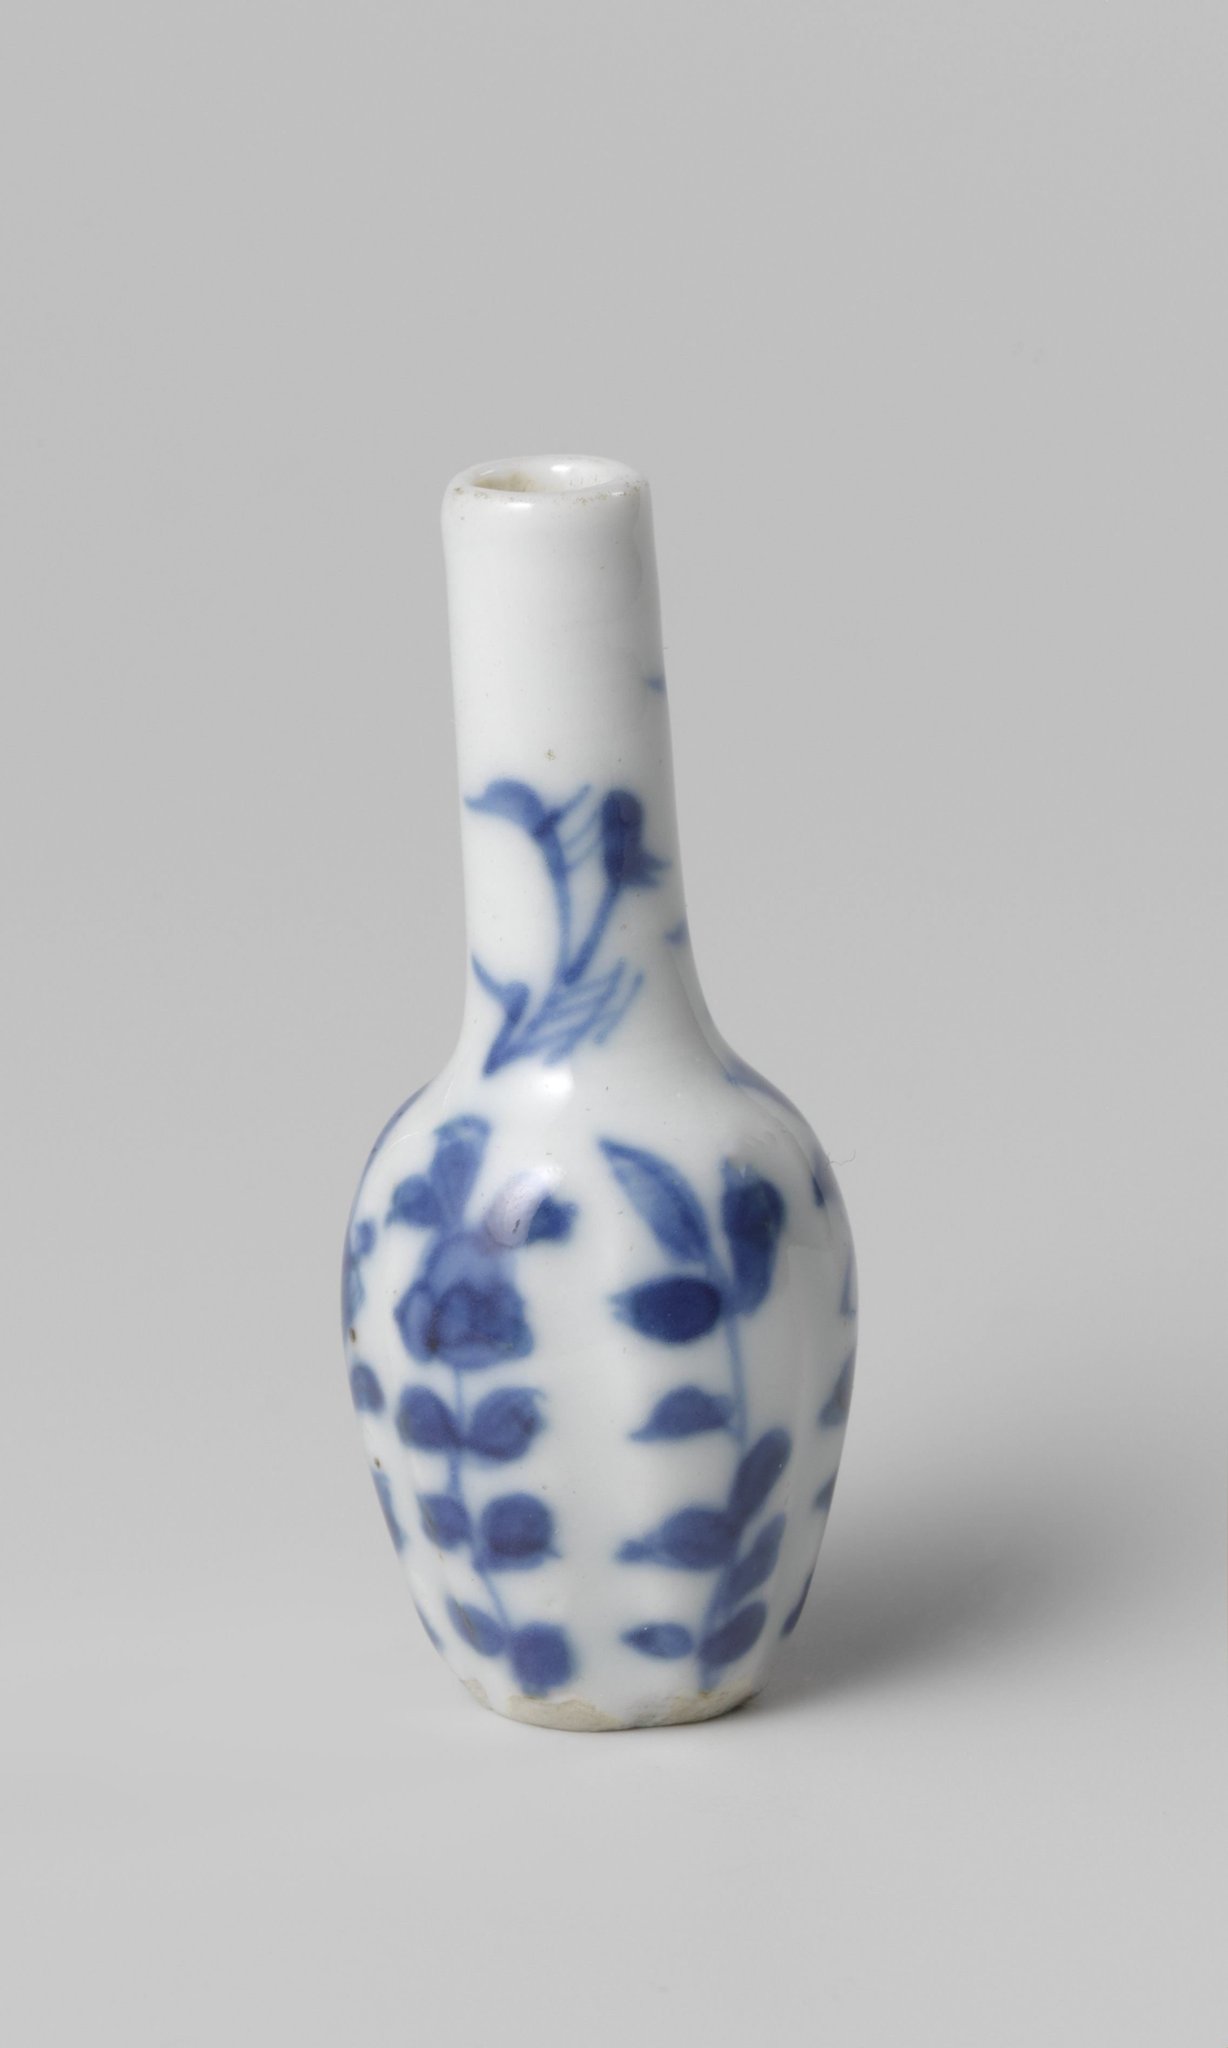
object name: vase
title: Miniature bottle vase with flowering plants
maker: Anonymous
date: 1675-1724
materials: cobalt, glaze, paint, porcelain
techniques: firing, turning, vitrification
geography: china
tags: ornament derived from plant forms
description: Miniatuur flesvormige vaas van porselein met een zeslobbig lichaam, beschilderd in onderglazuur blauw. Op de buik en nek bloeiende planten. Blauw-wit.